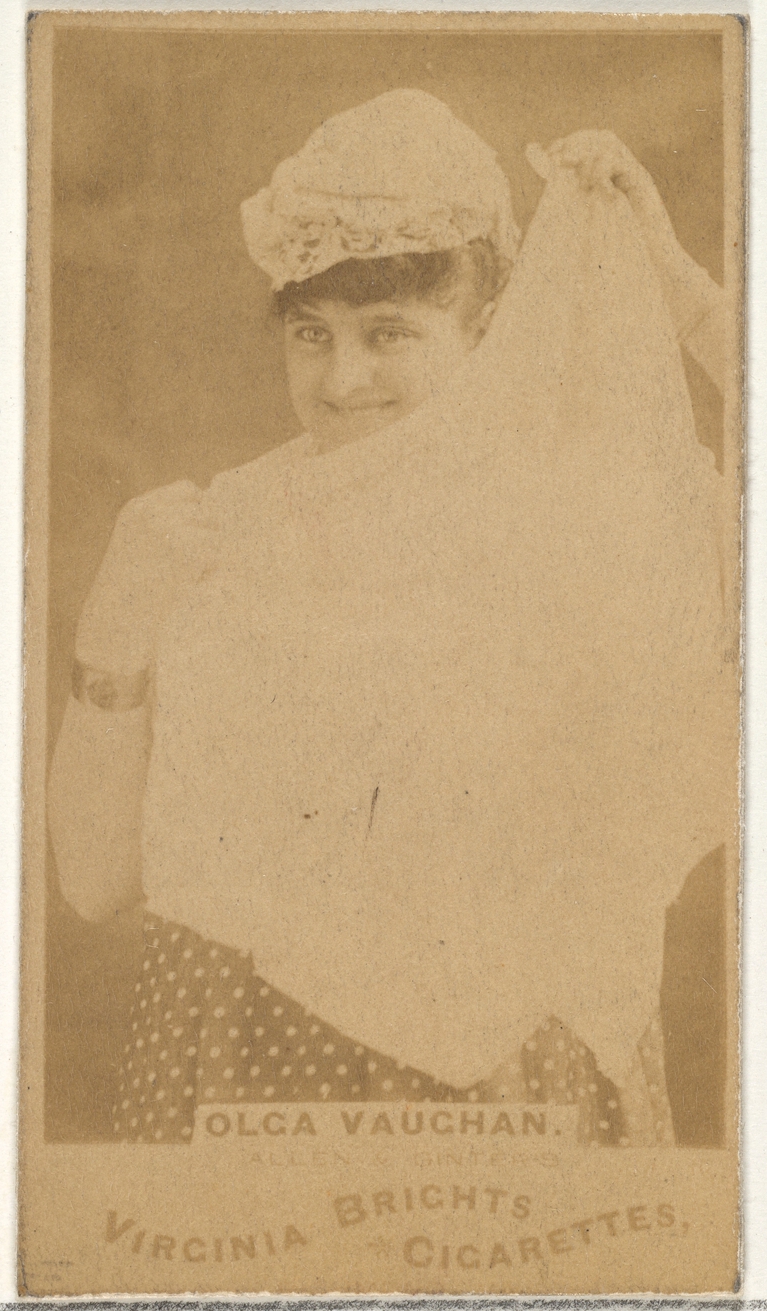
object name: photograph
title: Olga Vaughan, from the Actors and Actresses series (N45, Type 1) for Virginia Brights Cigarettes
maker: allen & ginter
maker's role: publisher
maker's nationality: american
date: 1888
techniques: albumen silver print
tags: portraits,women,actresses